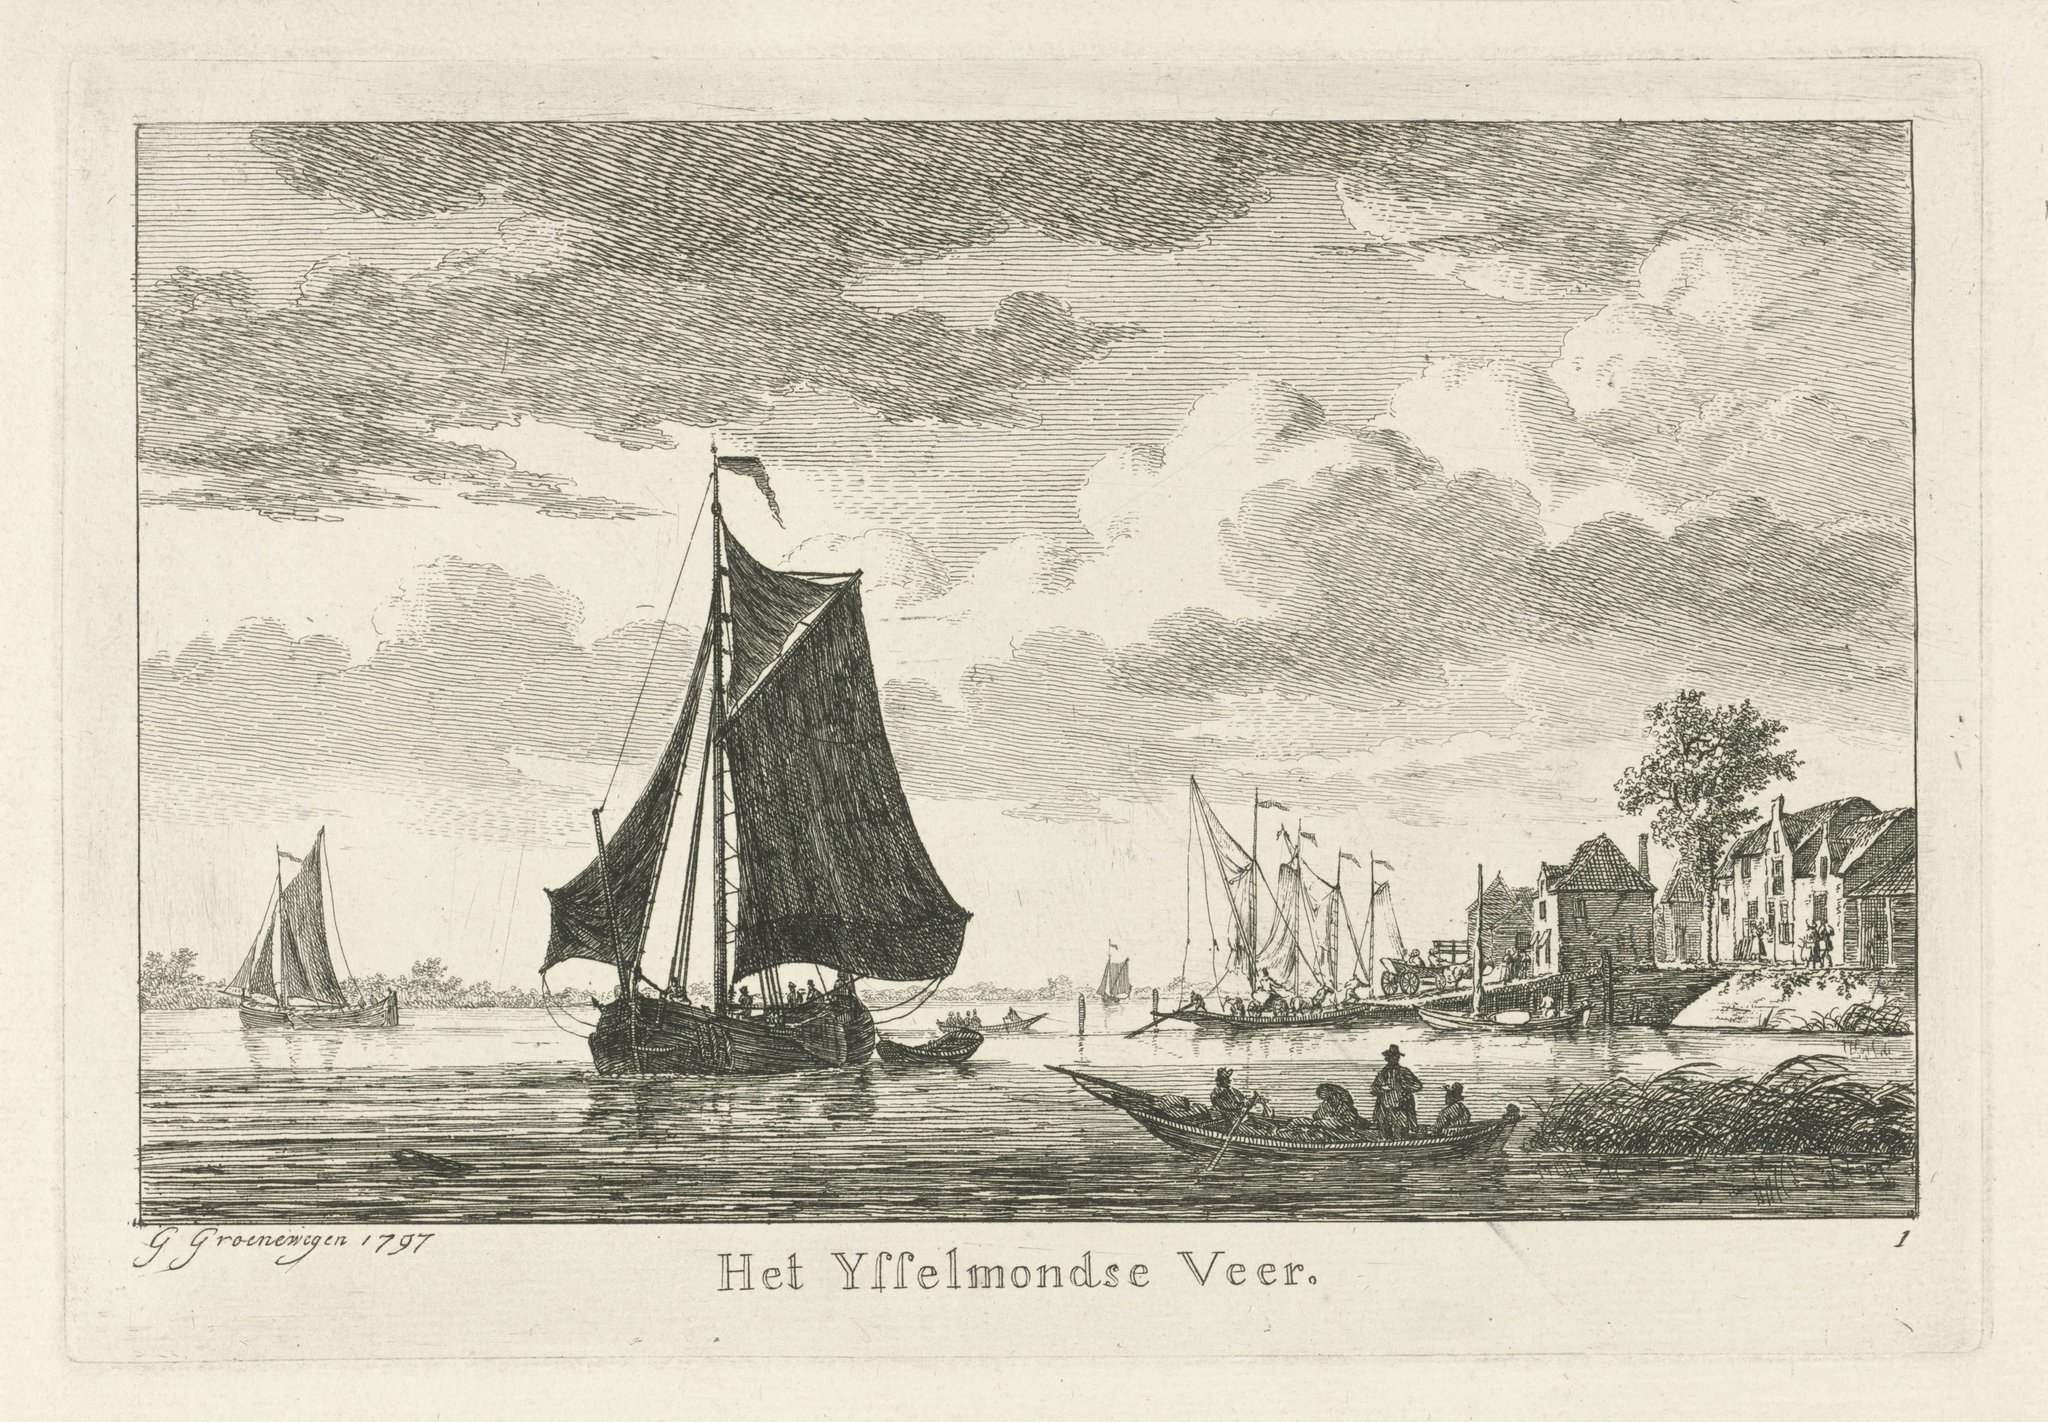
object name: print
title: Gezicht op het IJsselmondse Veer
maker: gerrit groenewegen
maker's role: draughtsman, print maker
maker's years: 1754-1826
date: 1797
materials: paper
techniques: etching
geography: rotterdam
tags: sailing-ship, sailing-boat, rowing-boat, canoe, etc., ferry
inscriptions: collector's mark: Lugt 2228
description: Gezicht op de Maas en het IJsselmondse Veer bij Kralingen, met op de voorgrond een roeiboot en een platbodem. Rechts de Schaardijk. Rechtsonder genummerd: 1. Deze prent maakt deel uit van een serie van zes prenten met Maasgezichten.